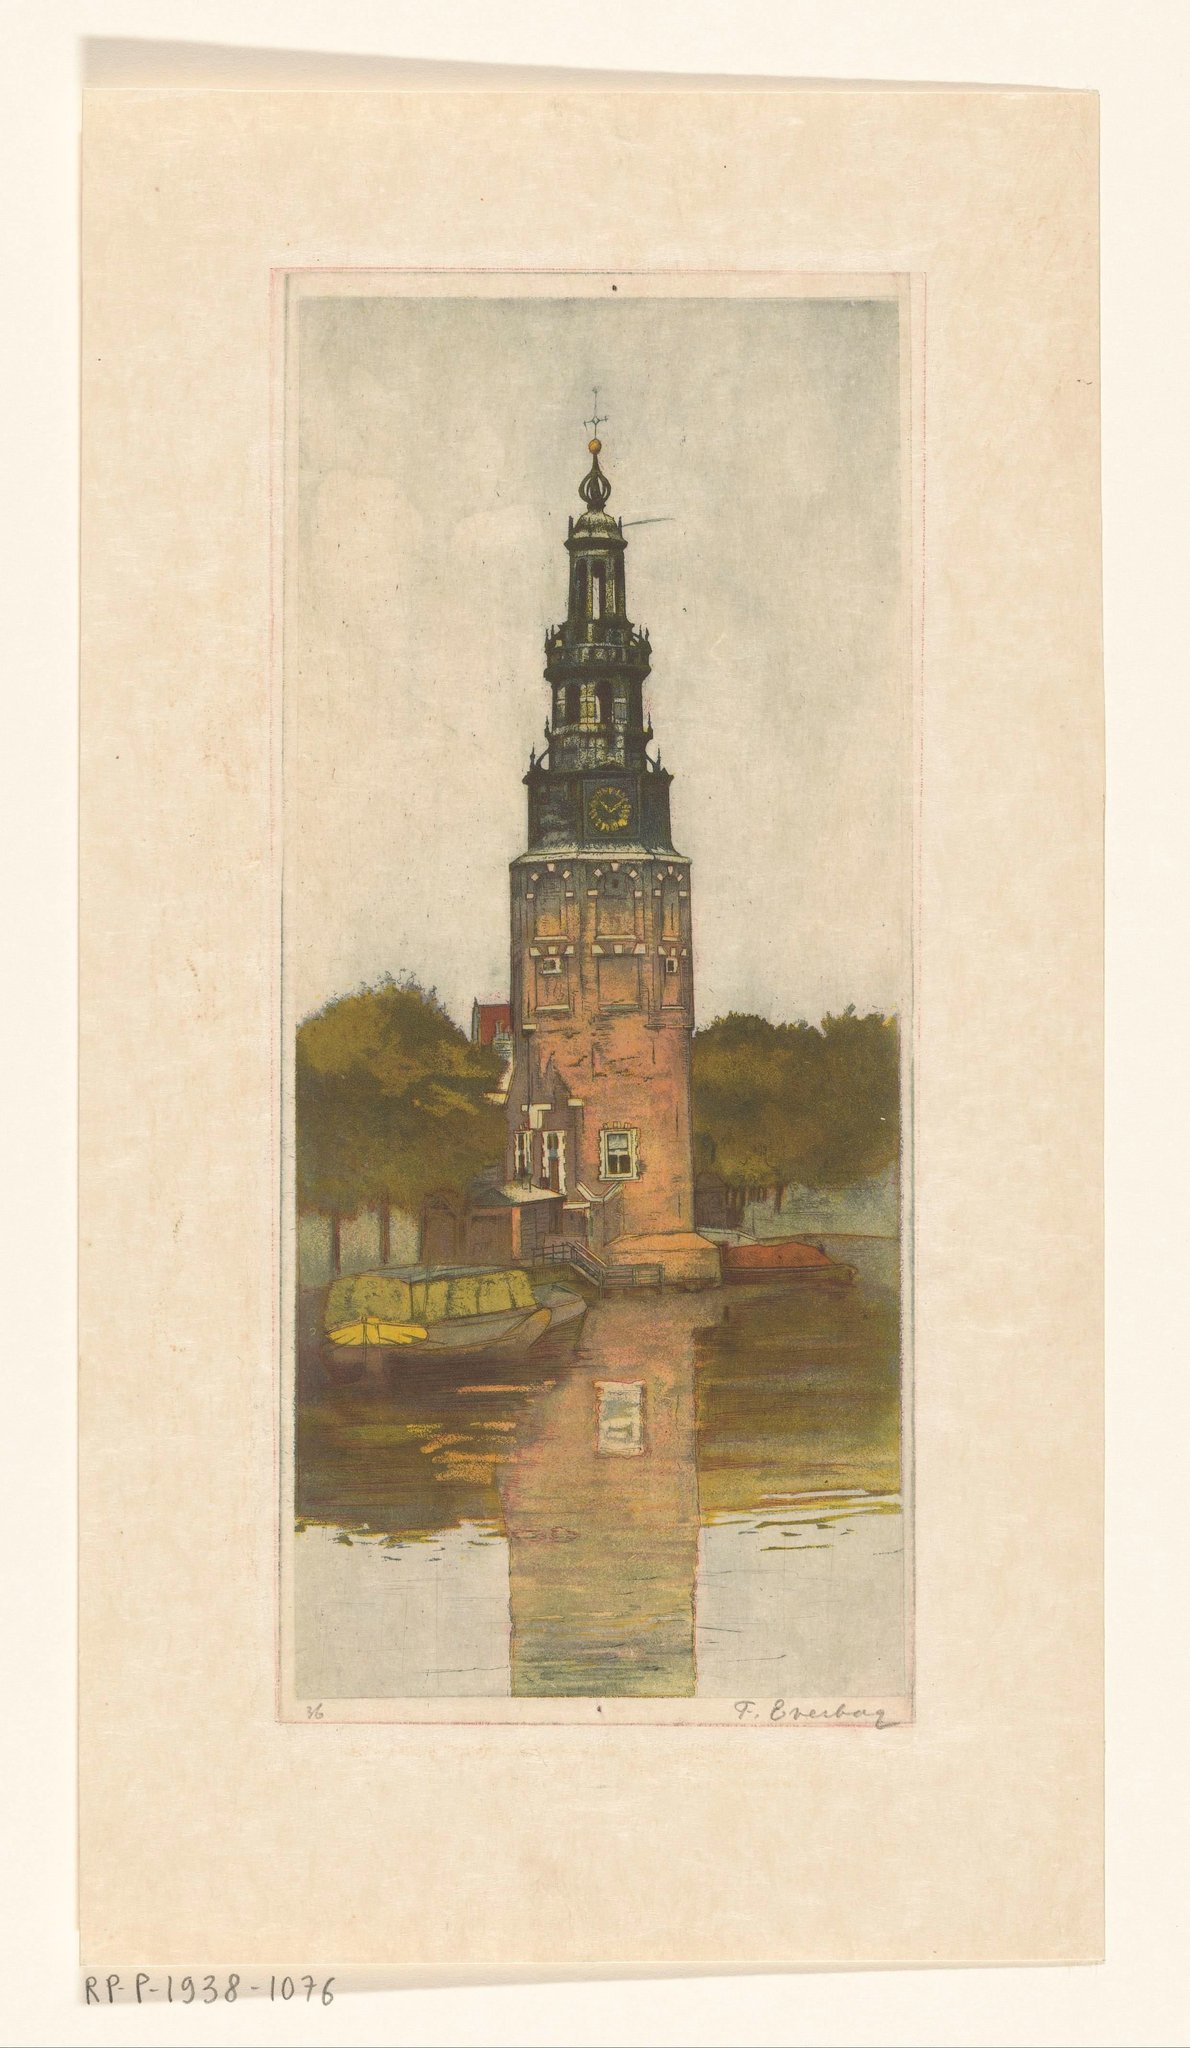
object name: print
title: Gezicht op de Montelbaanstoren te Amsterdam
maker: frans everbag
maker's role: draughtsman, print maker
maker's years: 1877-1947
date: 1903-1938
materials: paper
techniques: etching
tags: tower, clock tower ~ monumental adornment, canals, waters (in city)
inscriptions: collector's mark: Lugt 2760, collector's mark: Lugt 2228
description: Op de voorgrond twee schuiten en de reflectie van de Montelbaanstoren in het water.